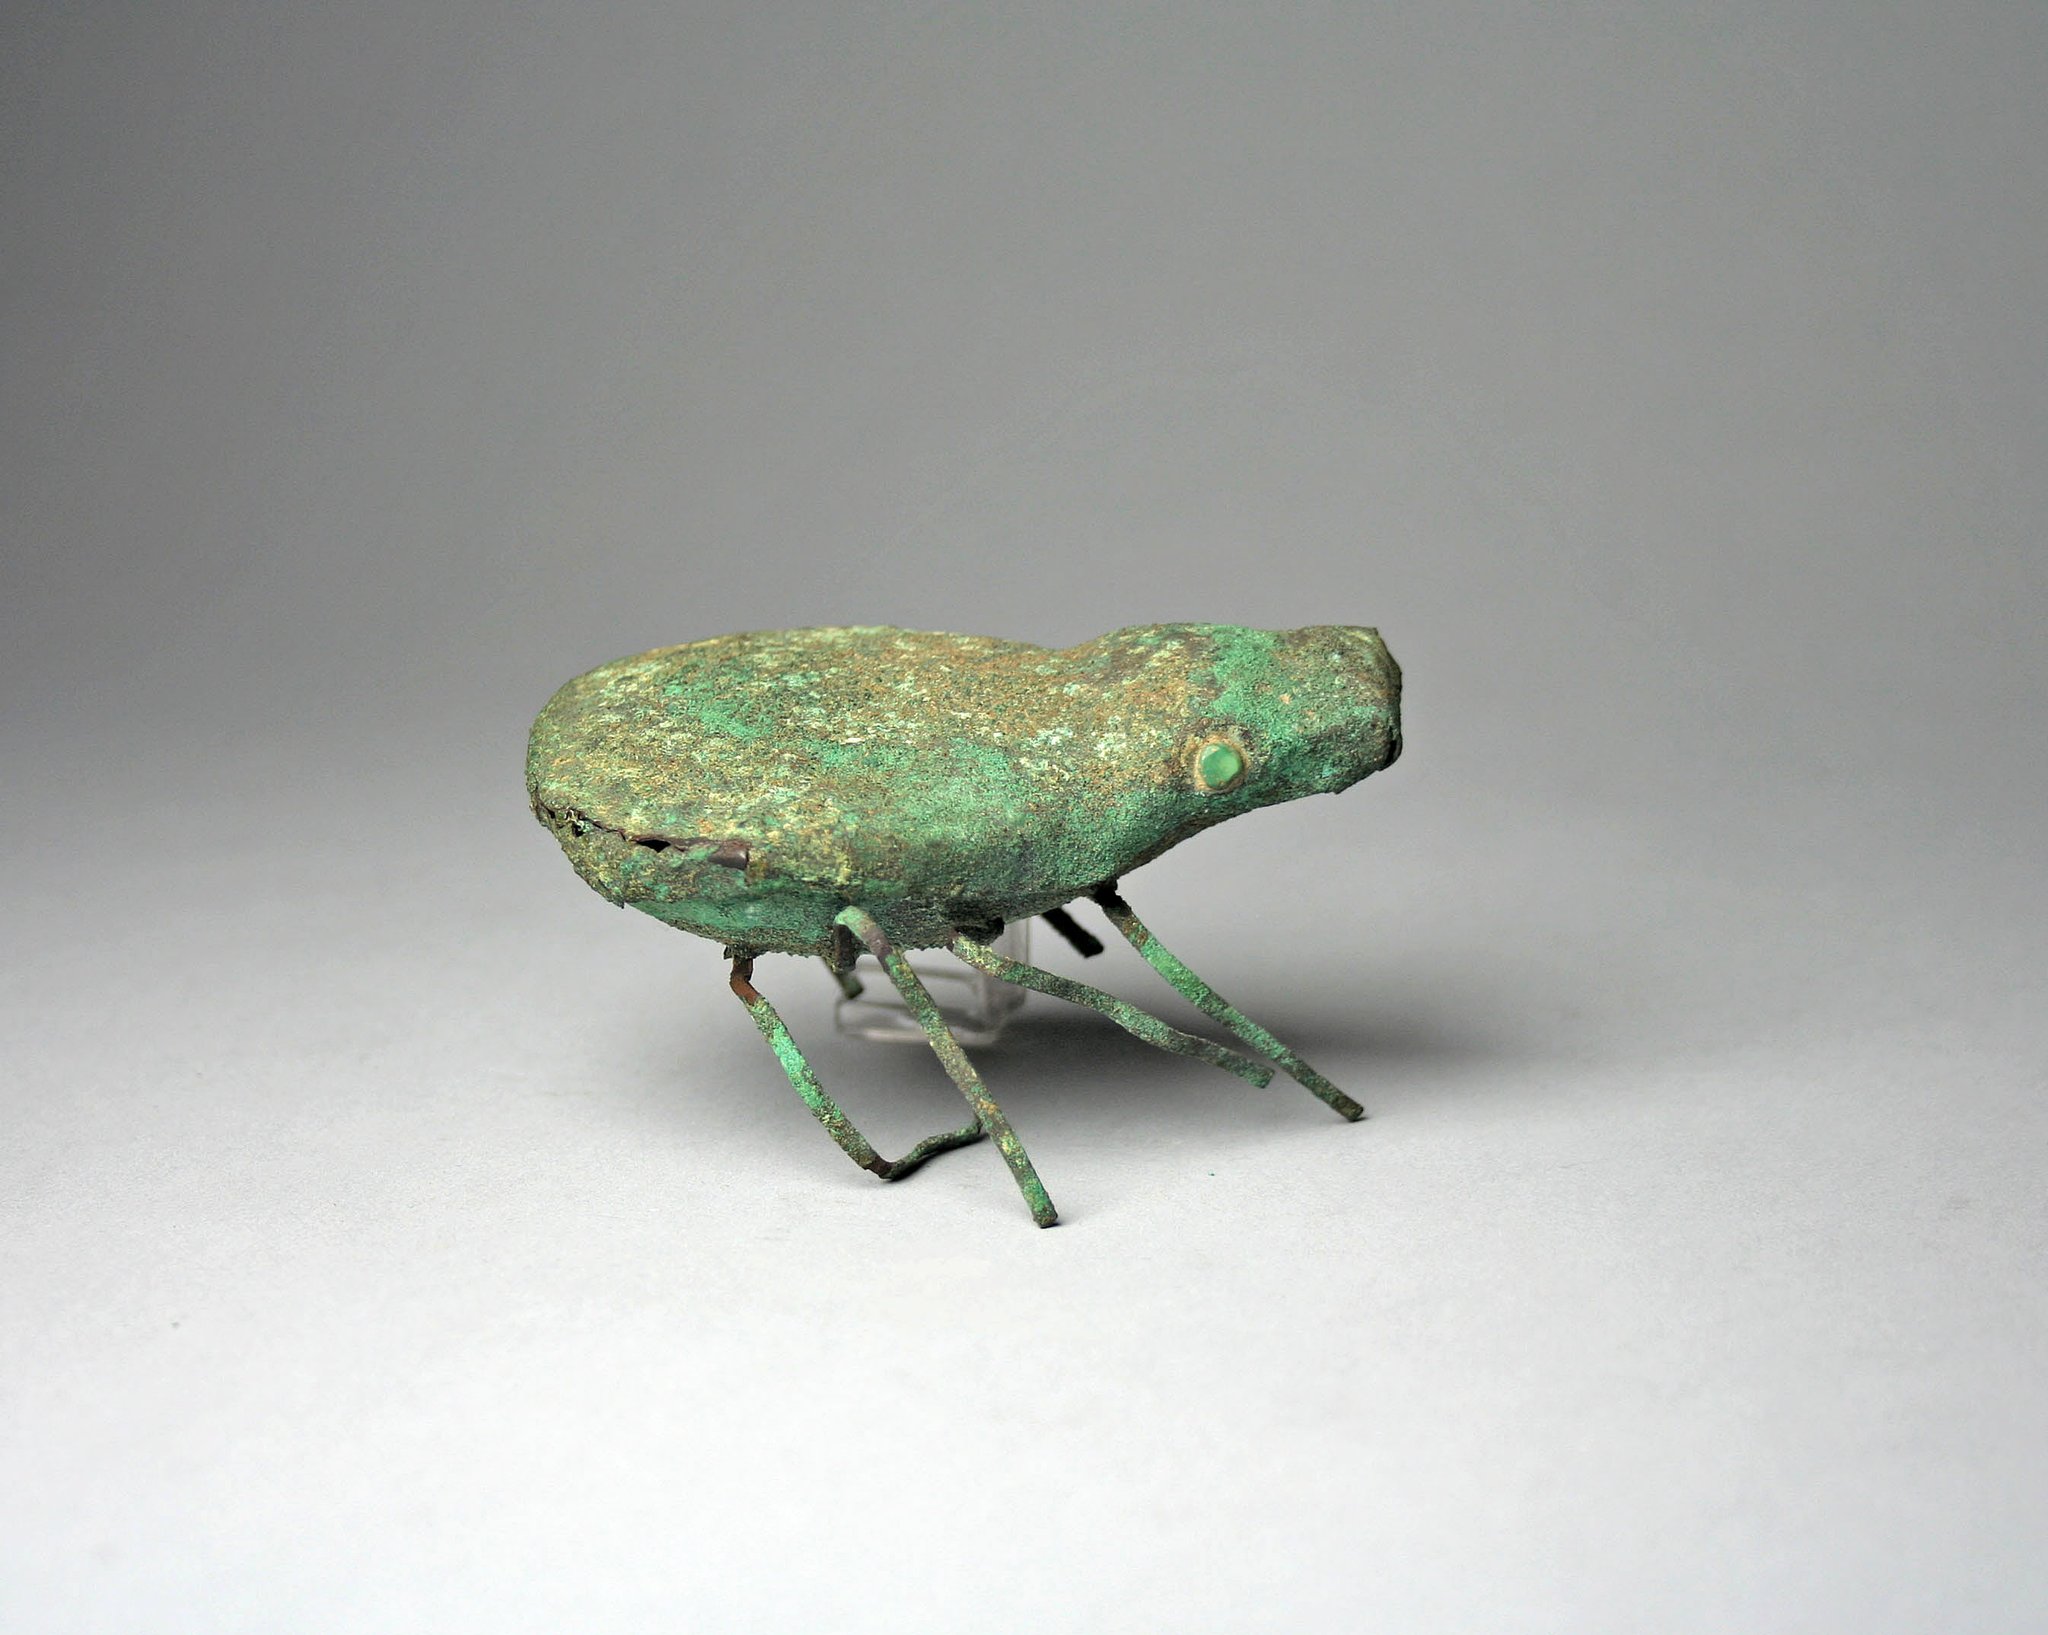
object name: ornament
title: Spider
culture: moche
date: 501-700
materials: metal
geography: peru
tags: insects